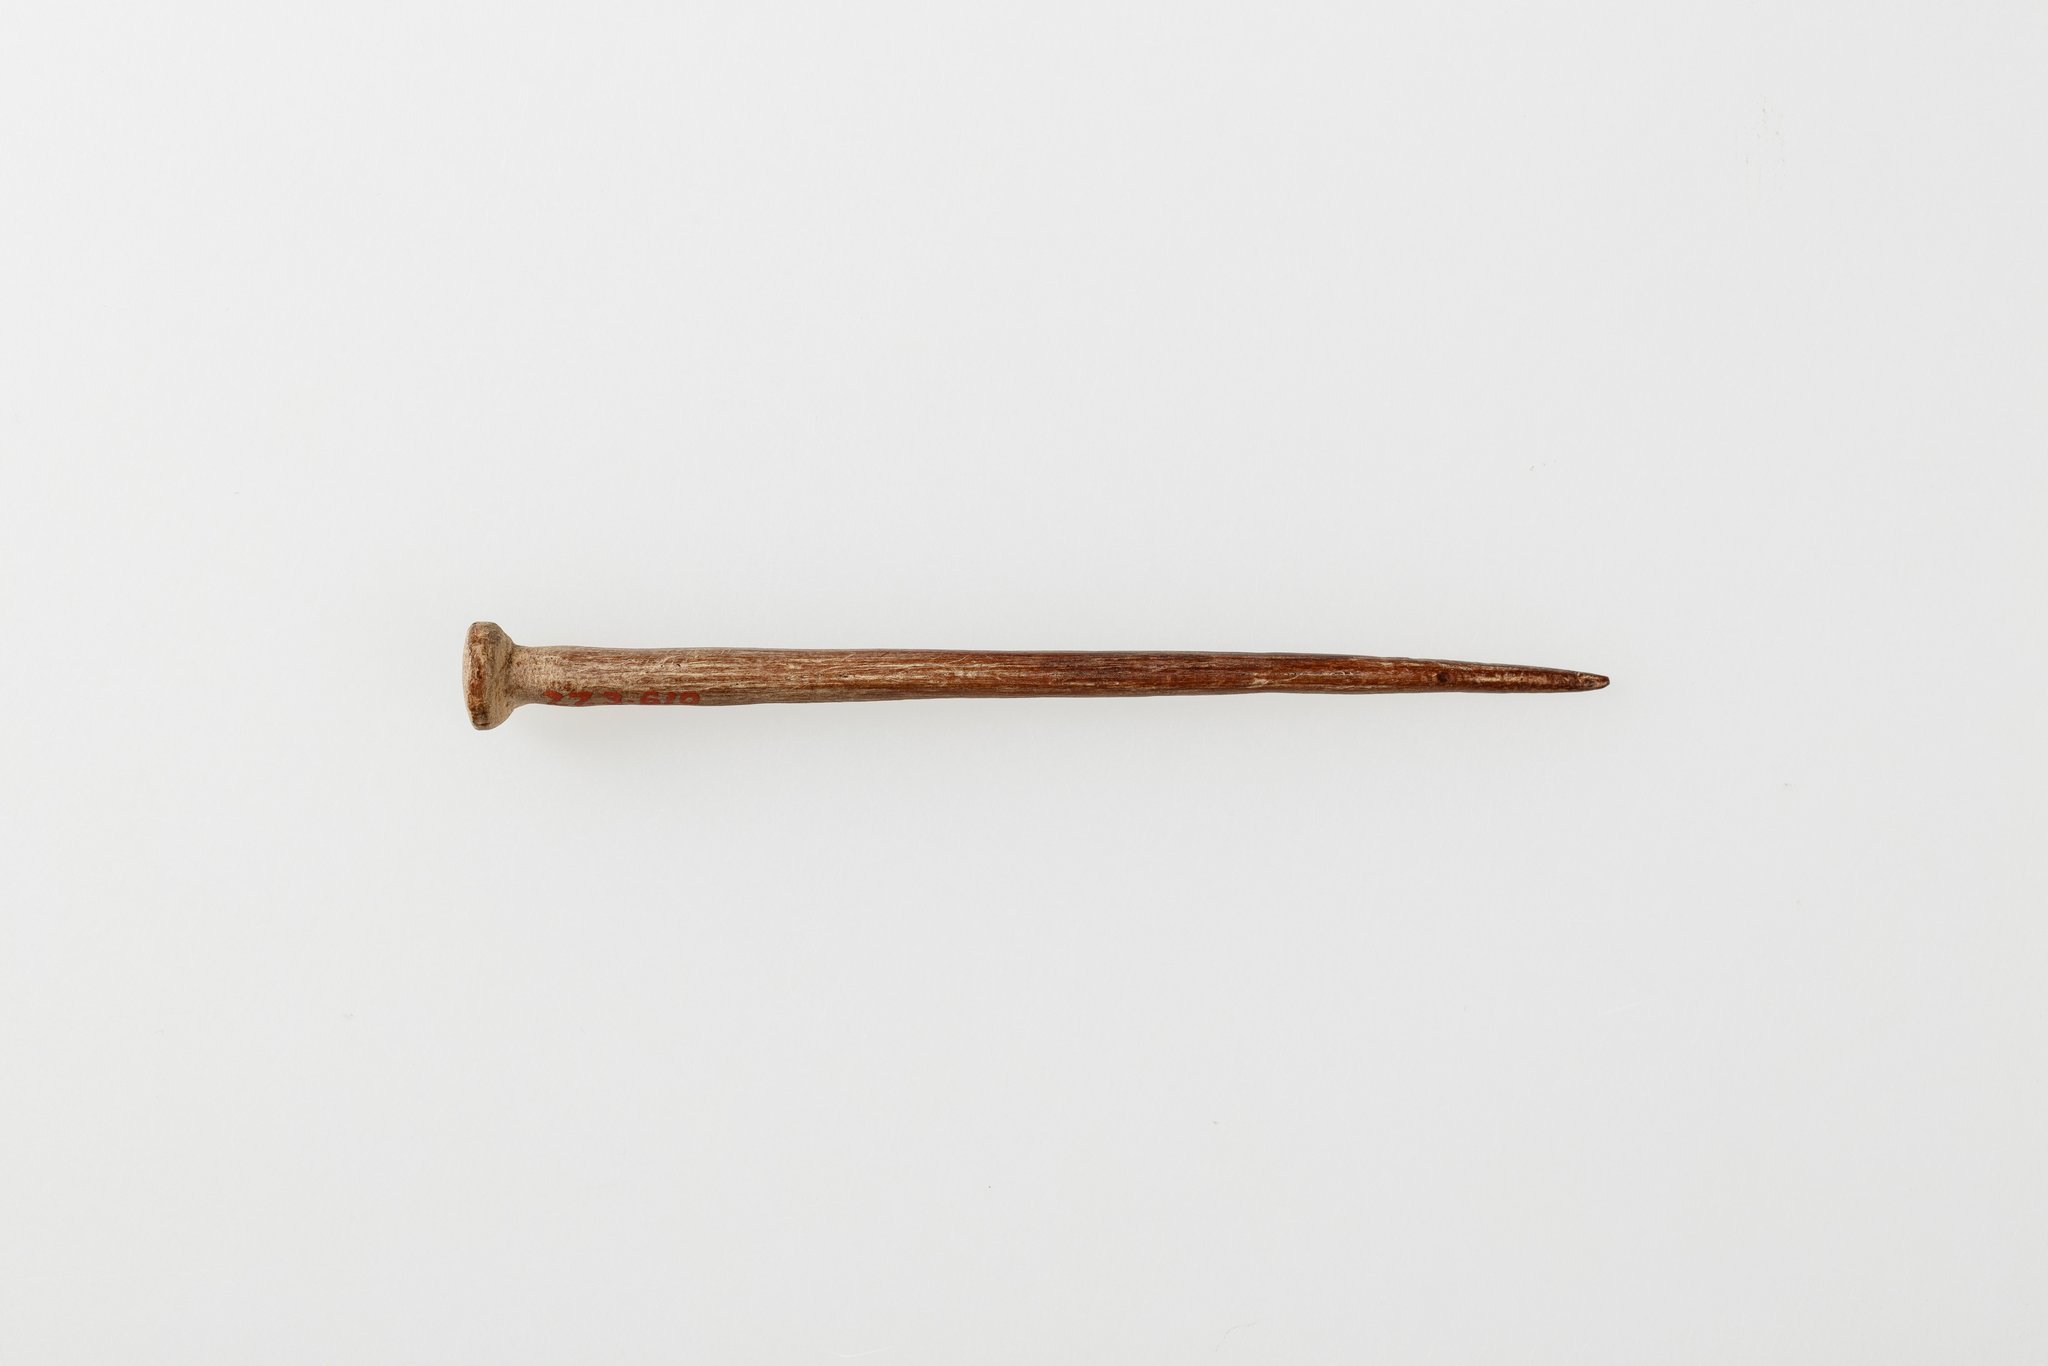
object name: hair pin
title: Pin (Hair Pin?)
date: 1070-525 BCE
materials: wood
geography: egypt